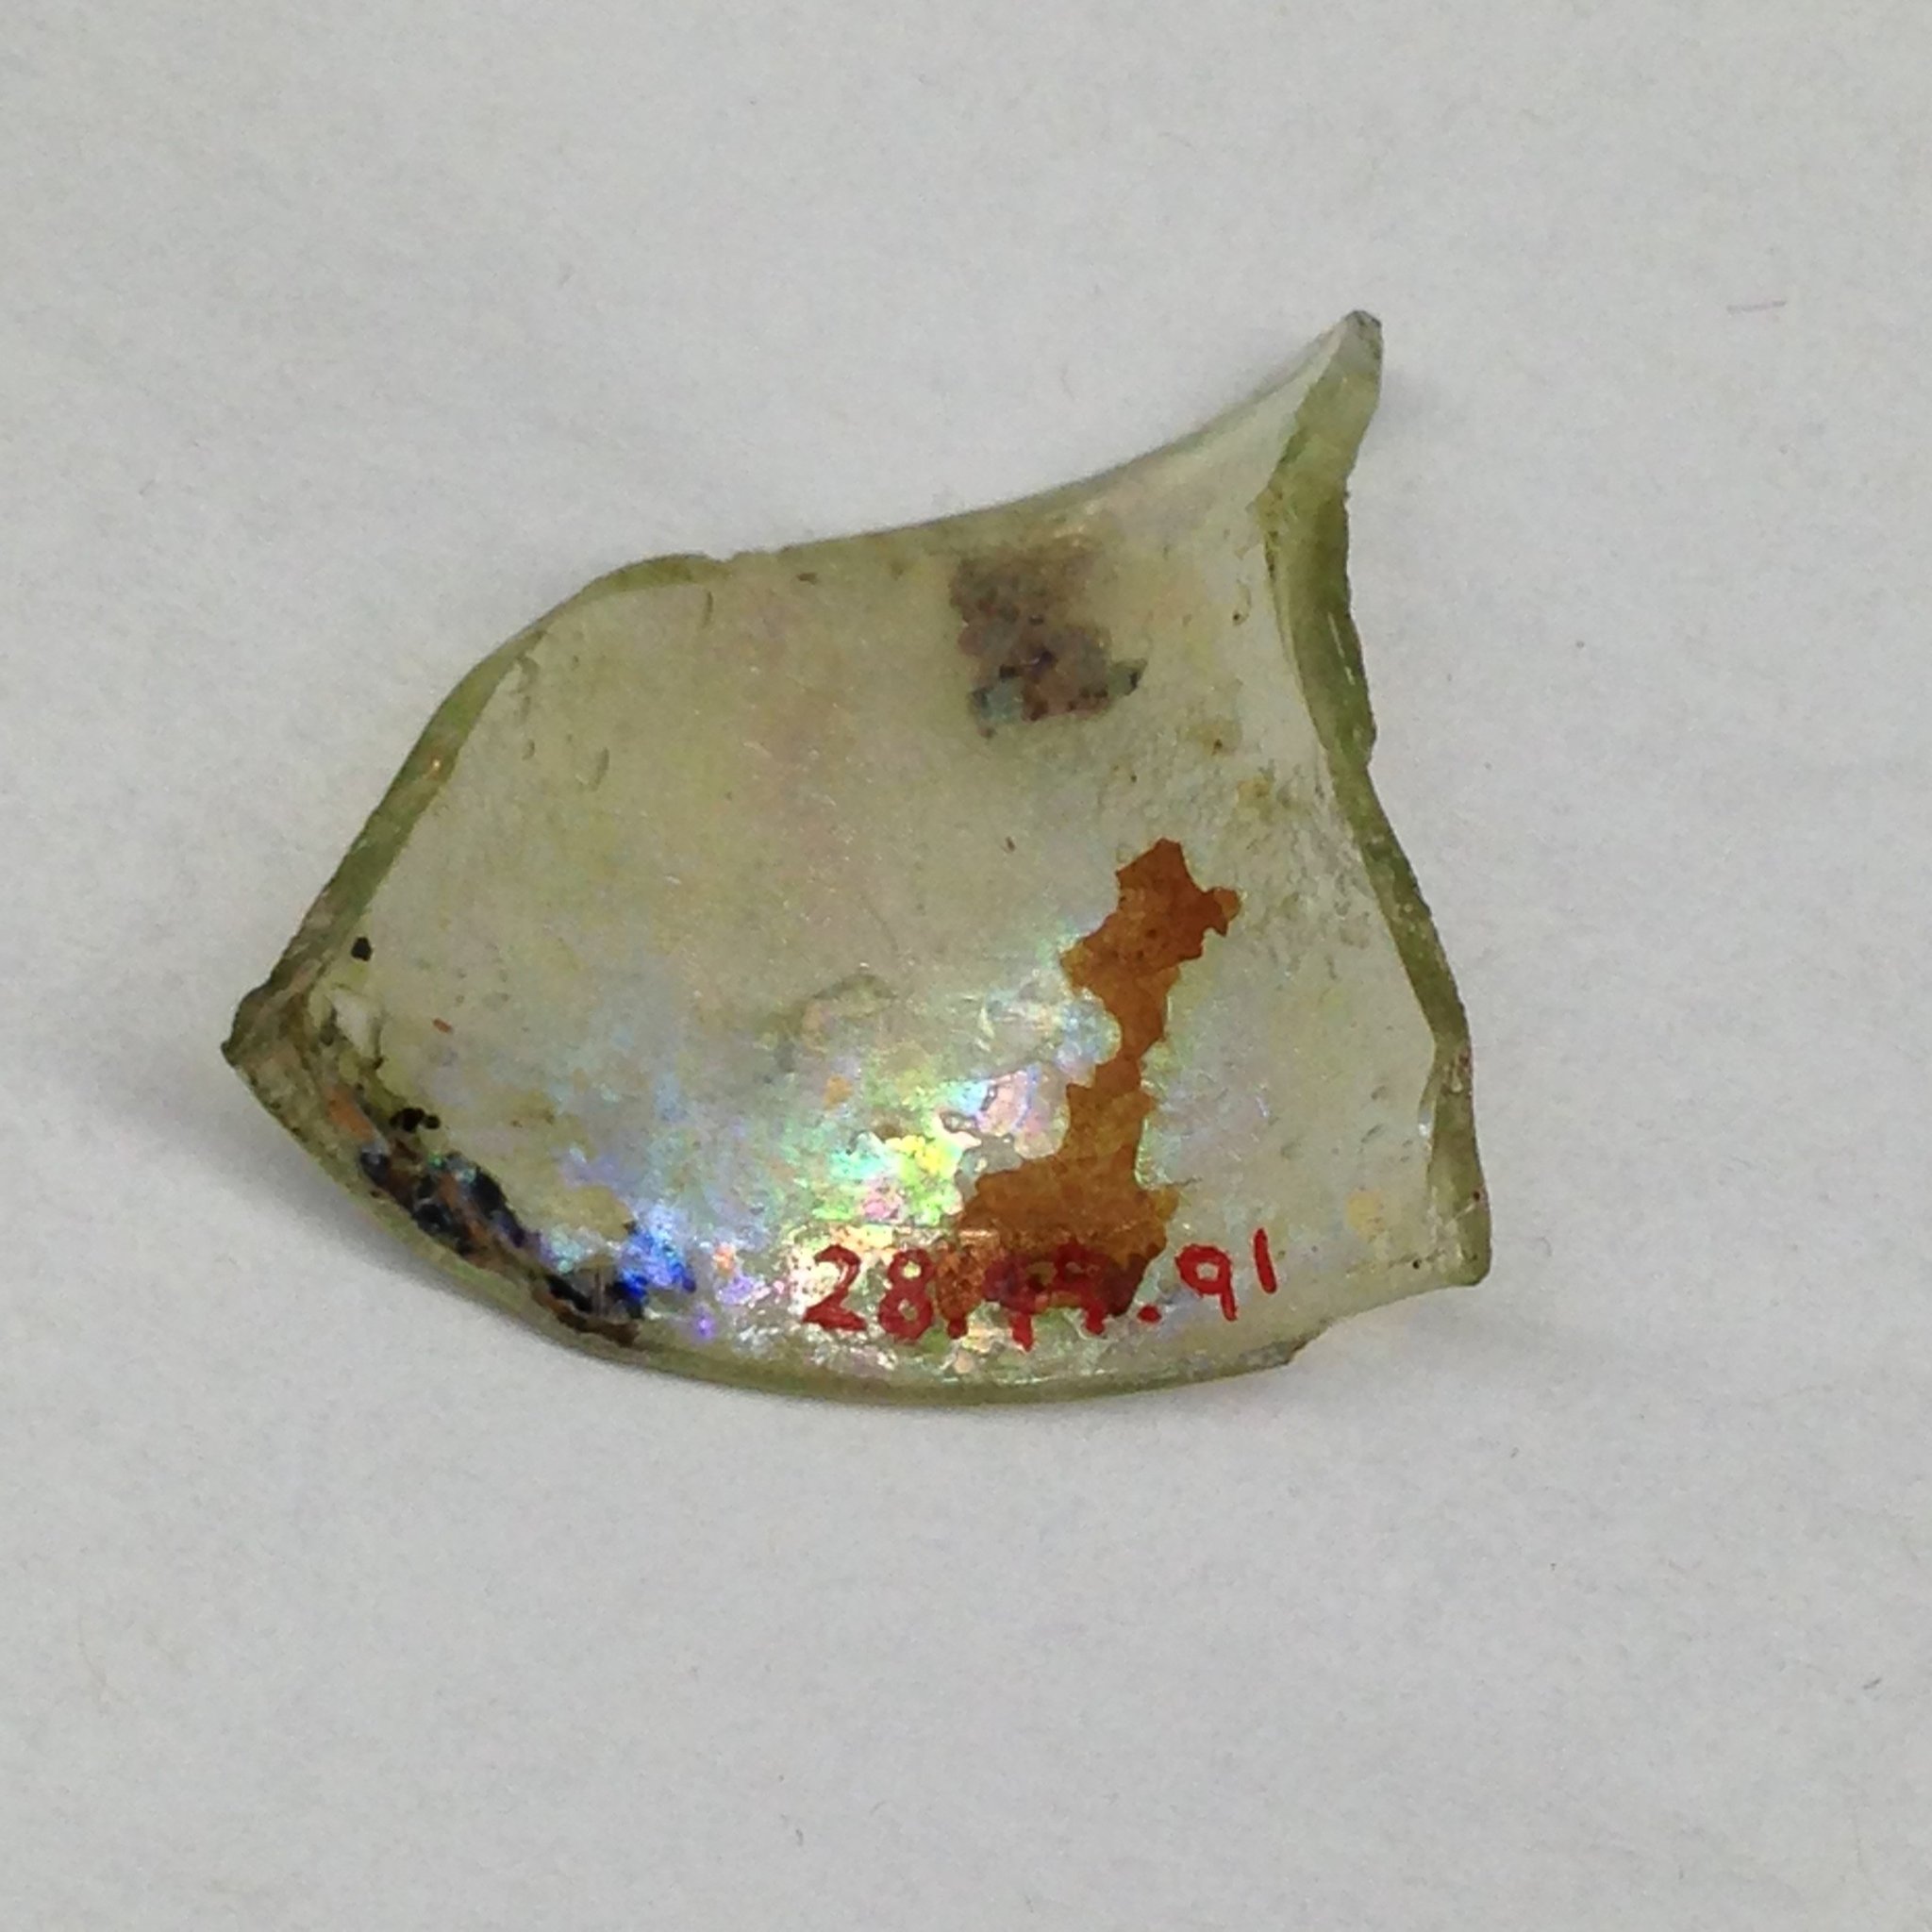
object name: fragment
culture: european or middle eastern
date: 1150-1250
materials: ceramic, glass